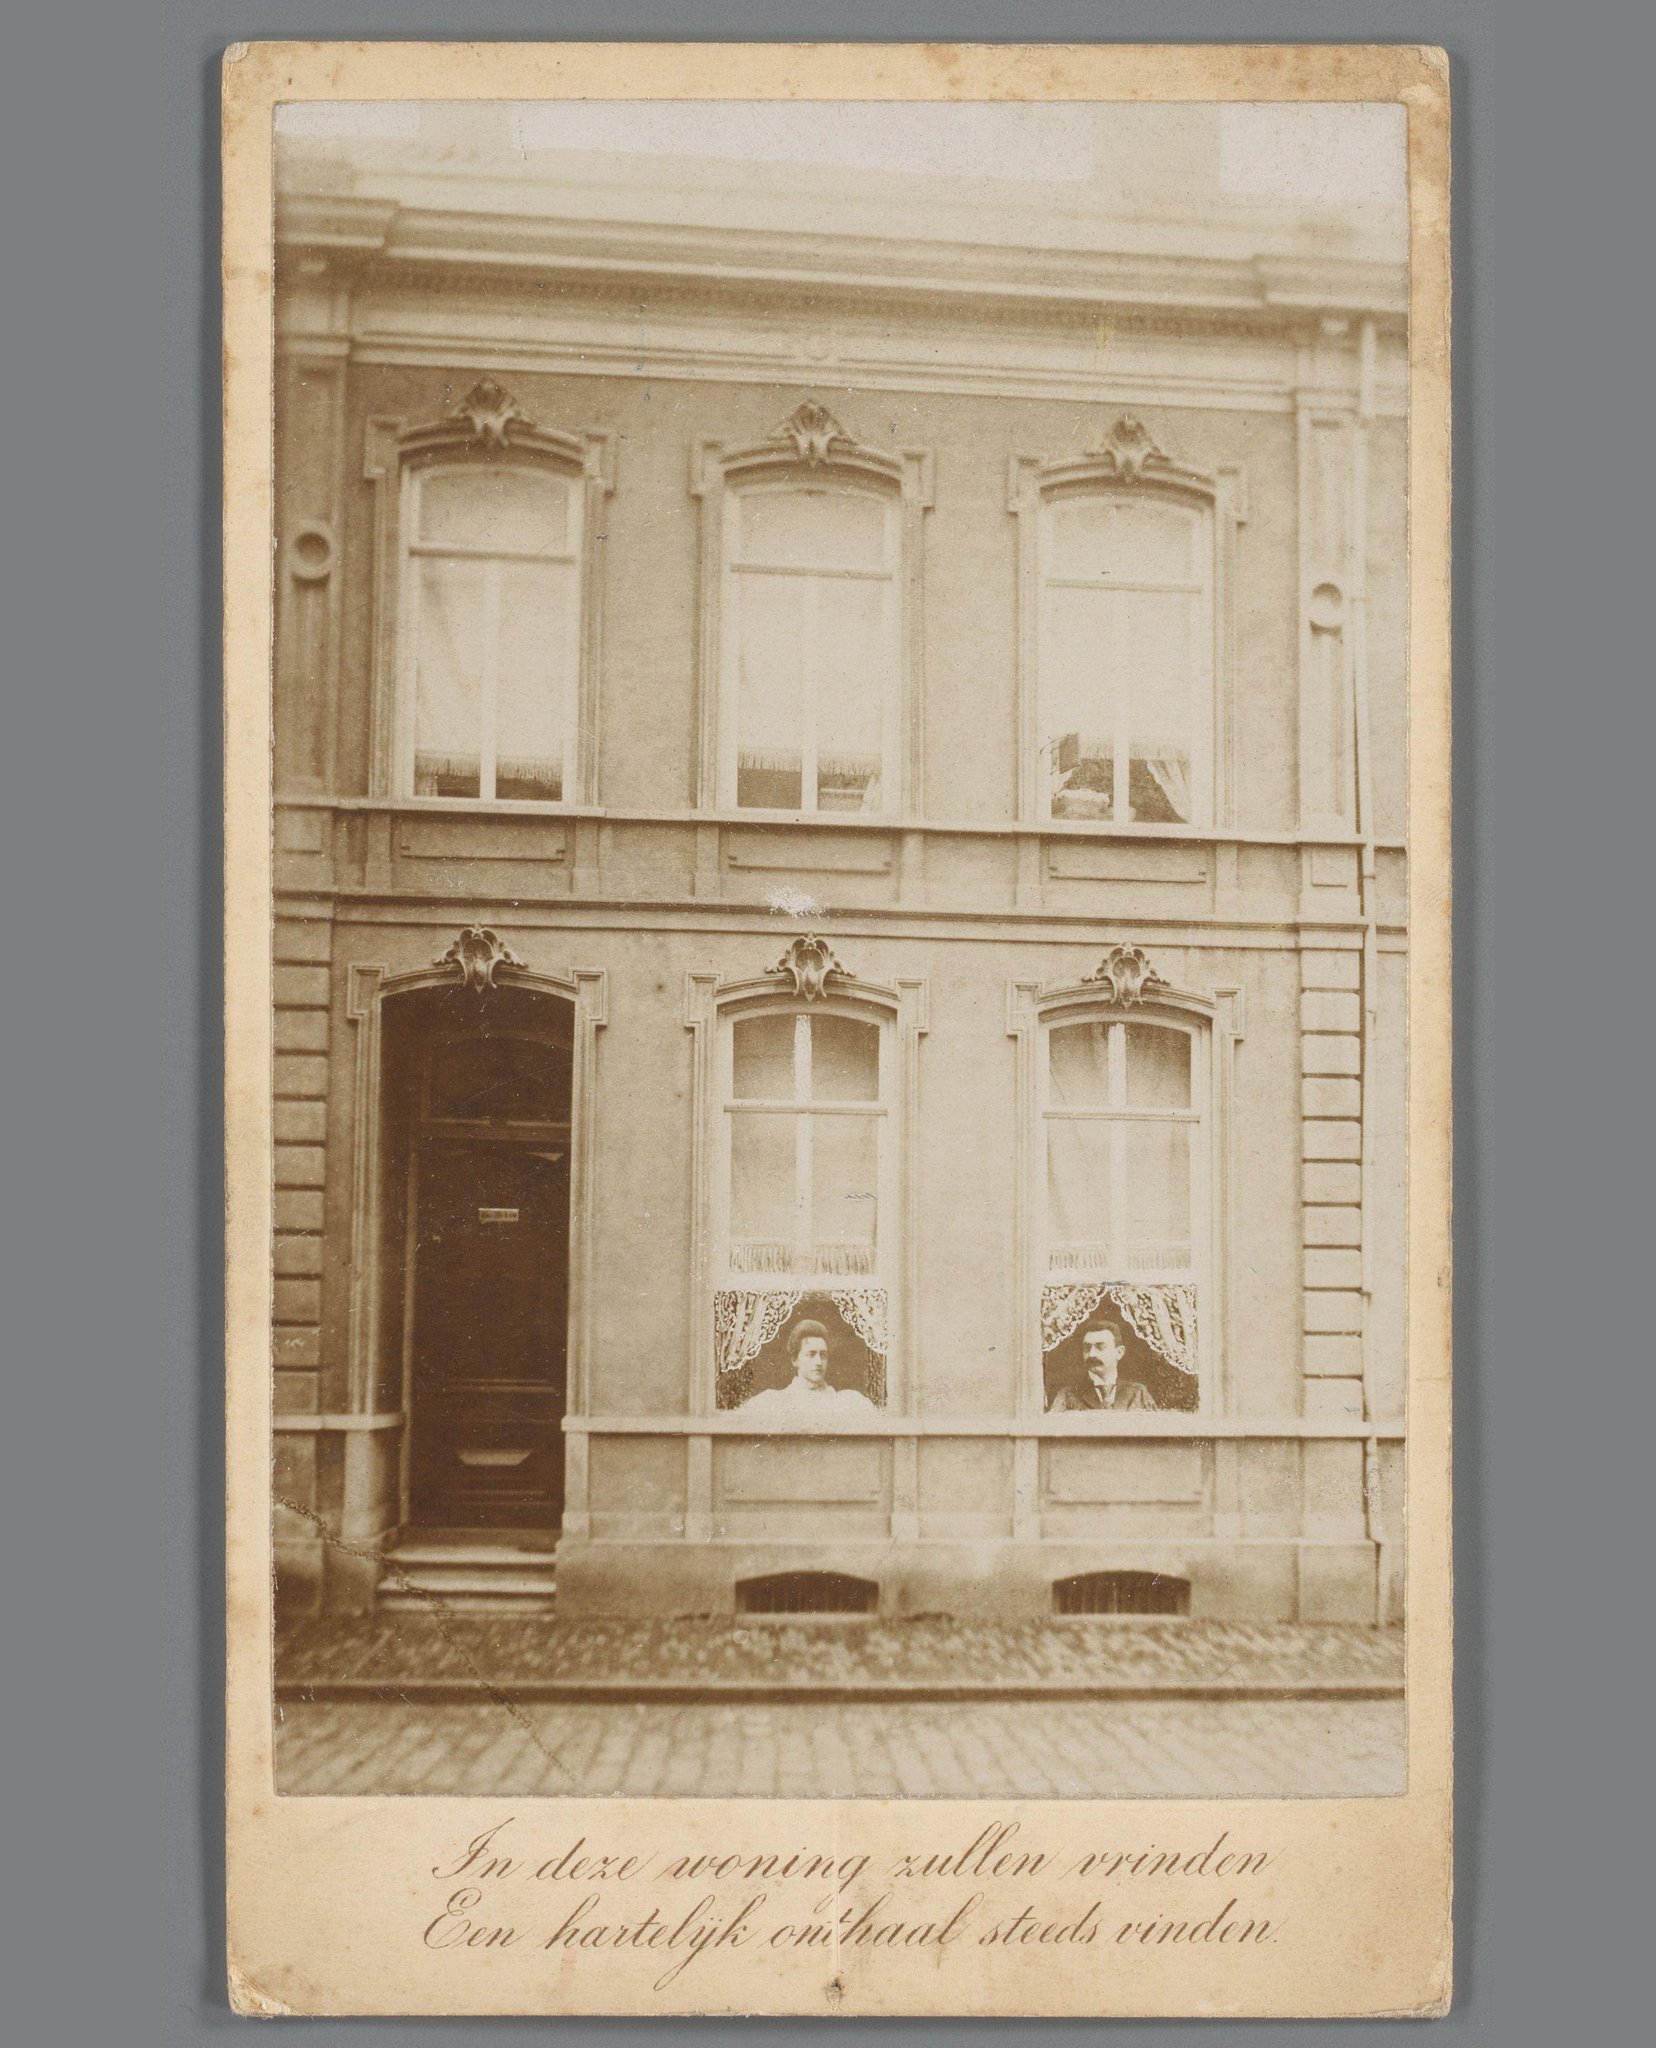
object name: cabinet photograph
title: Woning met bewoners achter het raam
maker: Anonymous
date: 1880-1910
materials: paper, cardboard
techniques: collodion silver print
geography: netherlands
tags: urban housing, adult woman, adult man